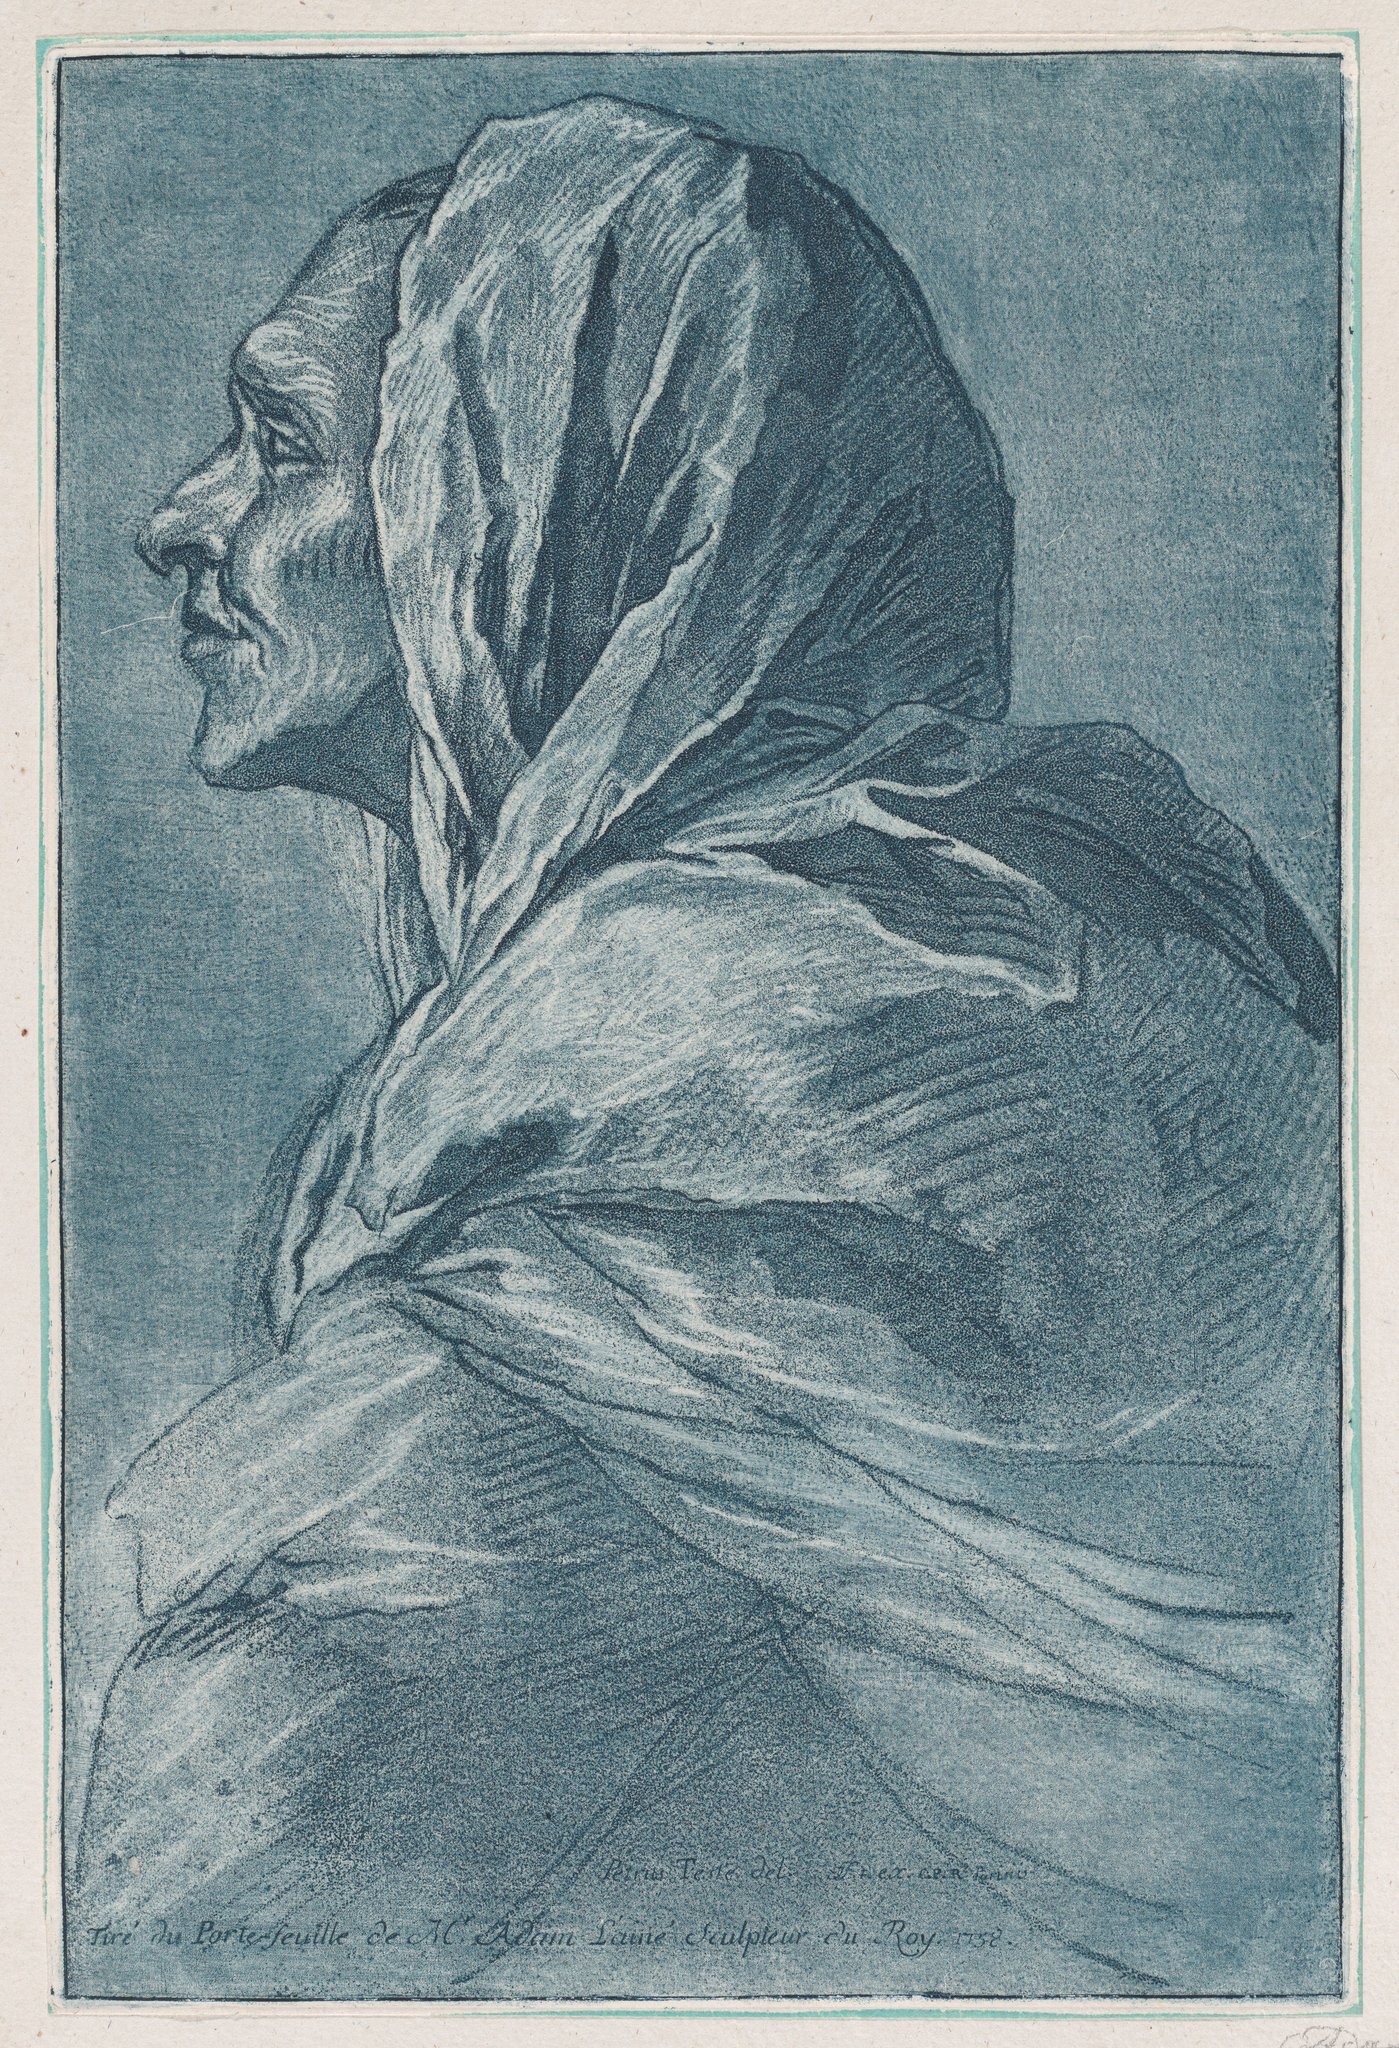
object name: facsimile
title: Head of a woman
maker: pietro testa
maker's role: artist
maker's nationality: italian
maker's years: 1612-1650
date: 1758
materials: ink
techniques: etching, printing